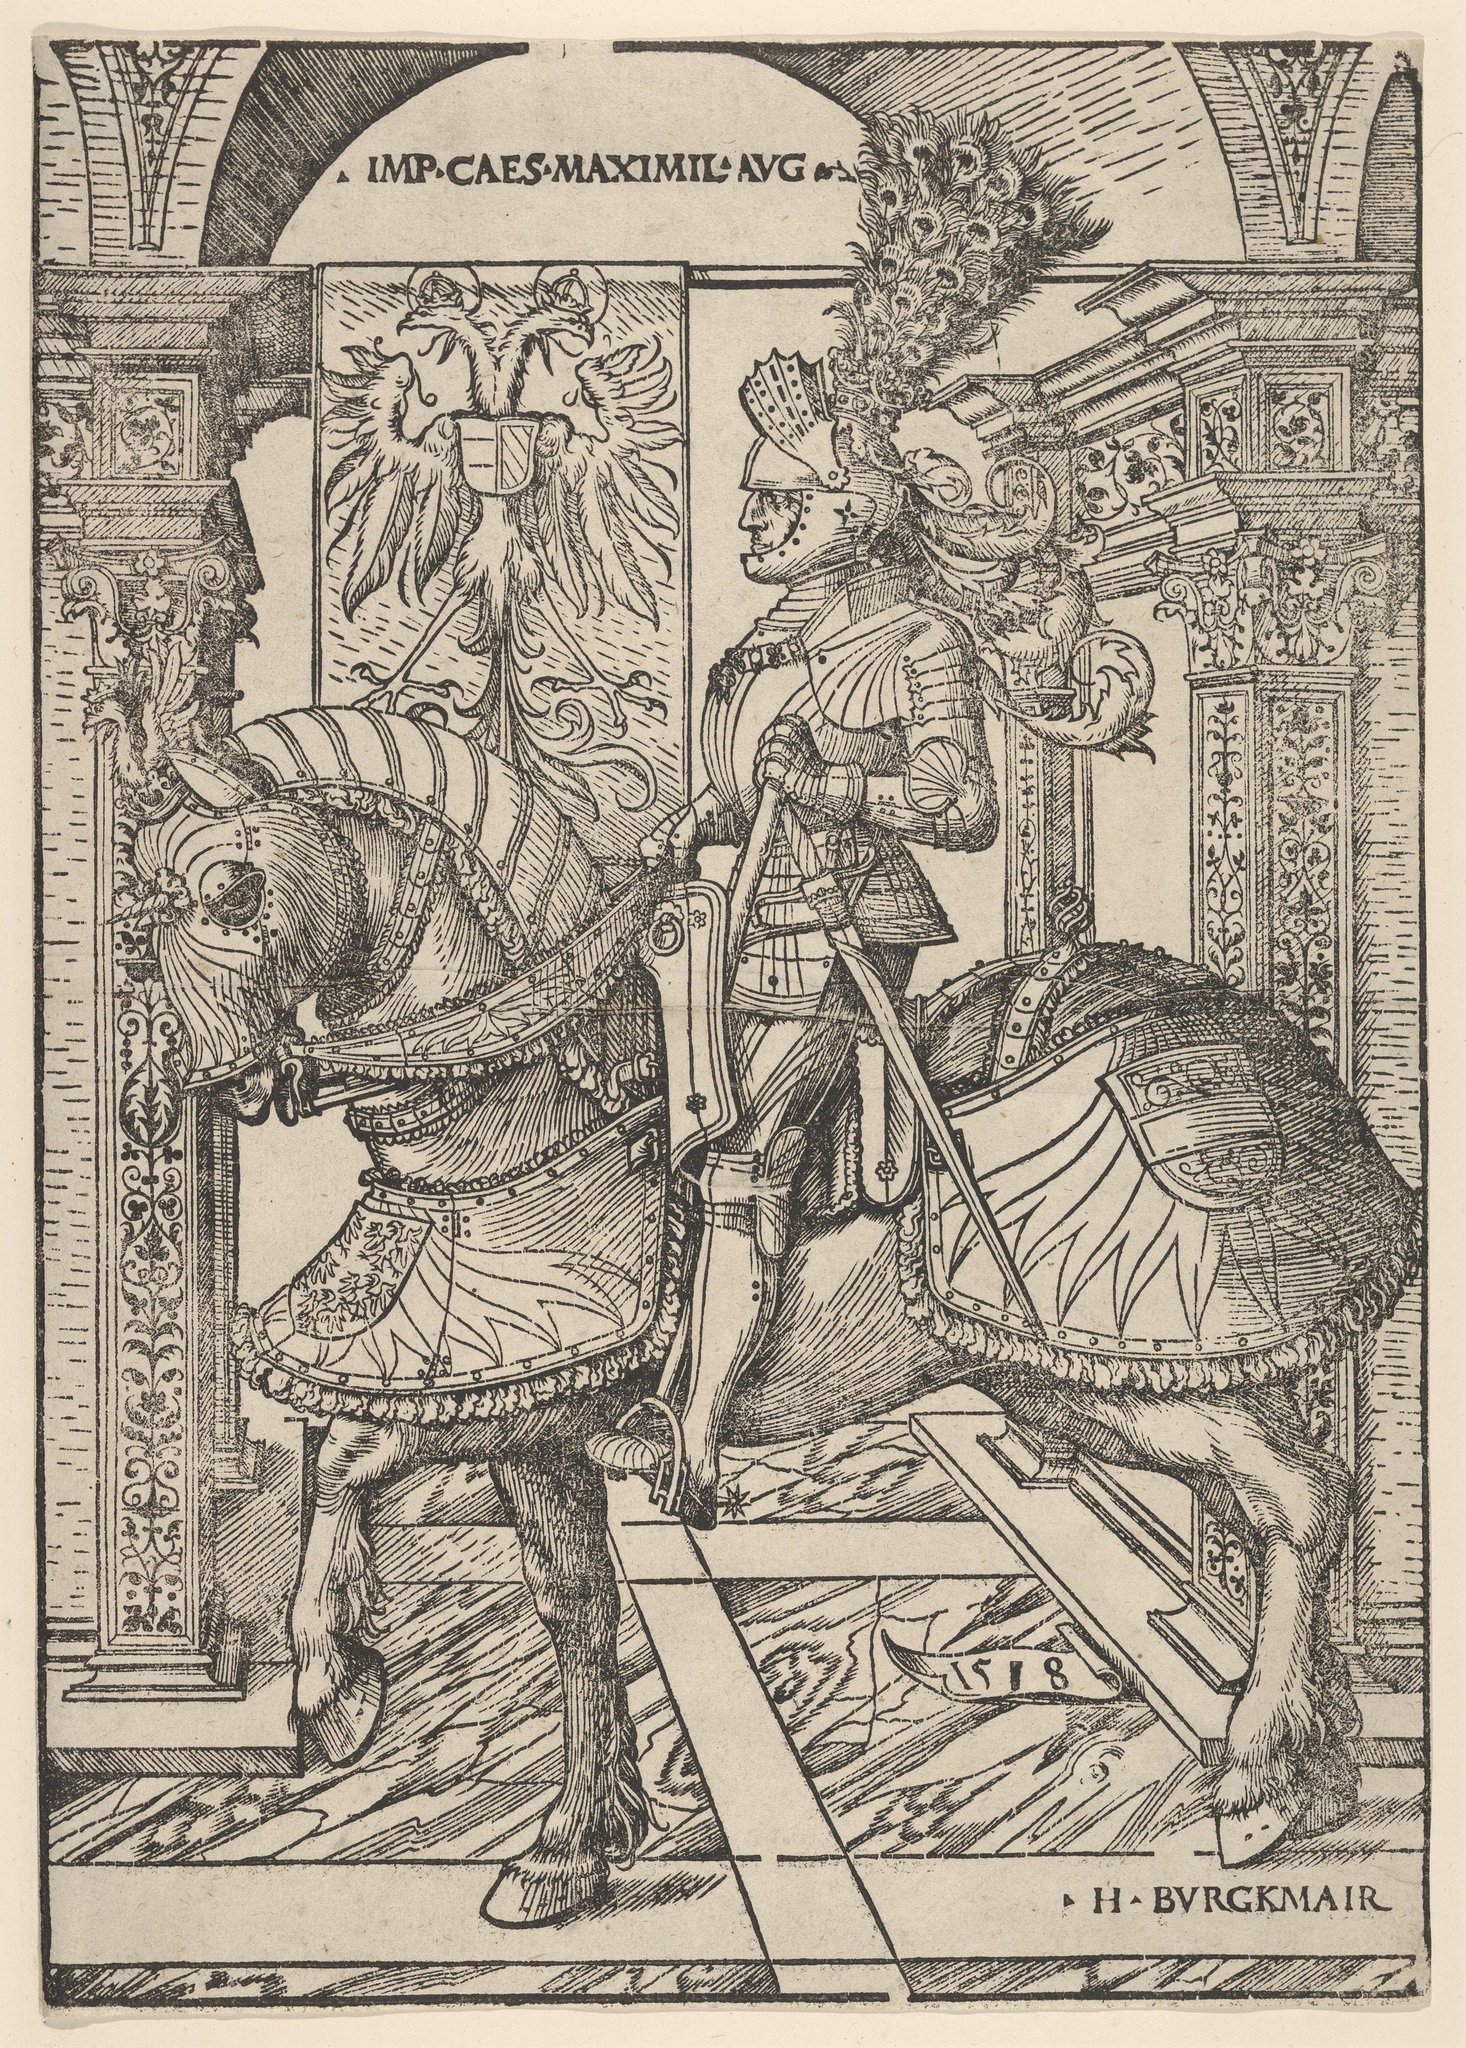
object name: print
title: Emperor Maximilian I on Horseback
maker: hans burgkmair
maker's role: artist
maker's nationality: german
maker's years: 1473-1531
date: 1518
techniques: woodcut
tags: swords,kings,horses